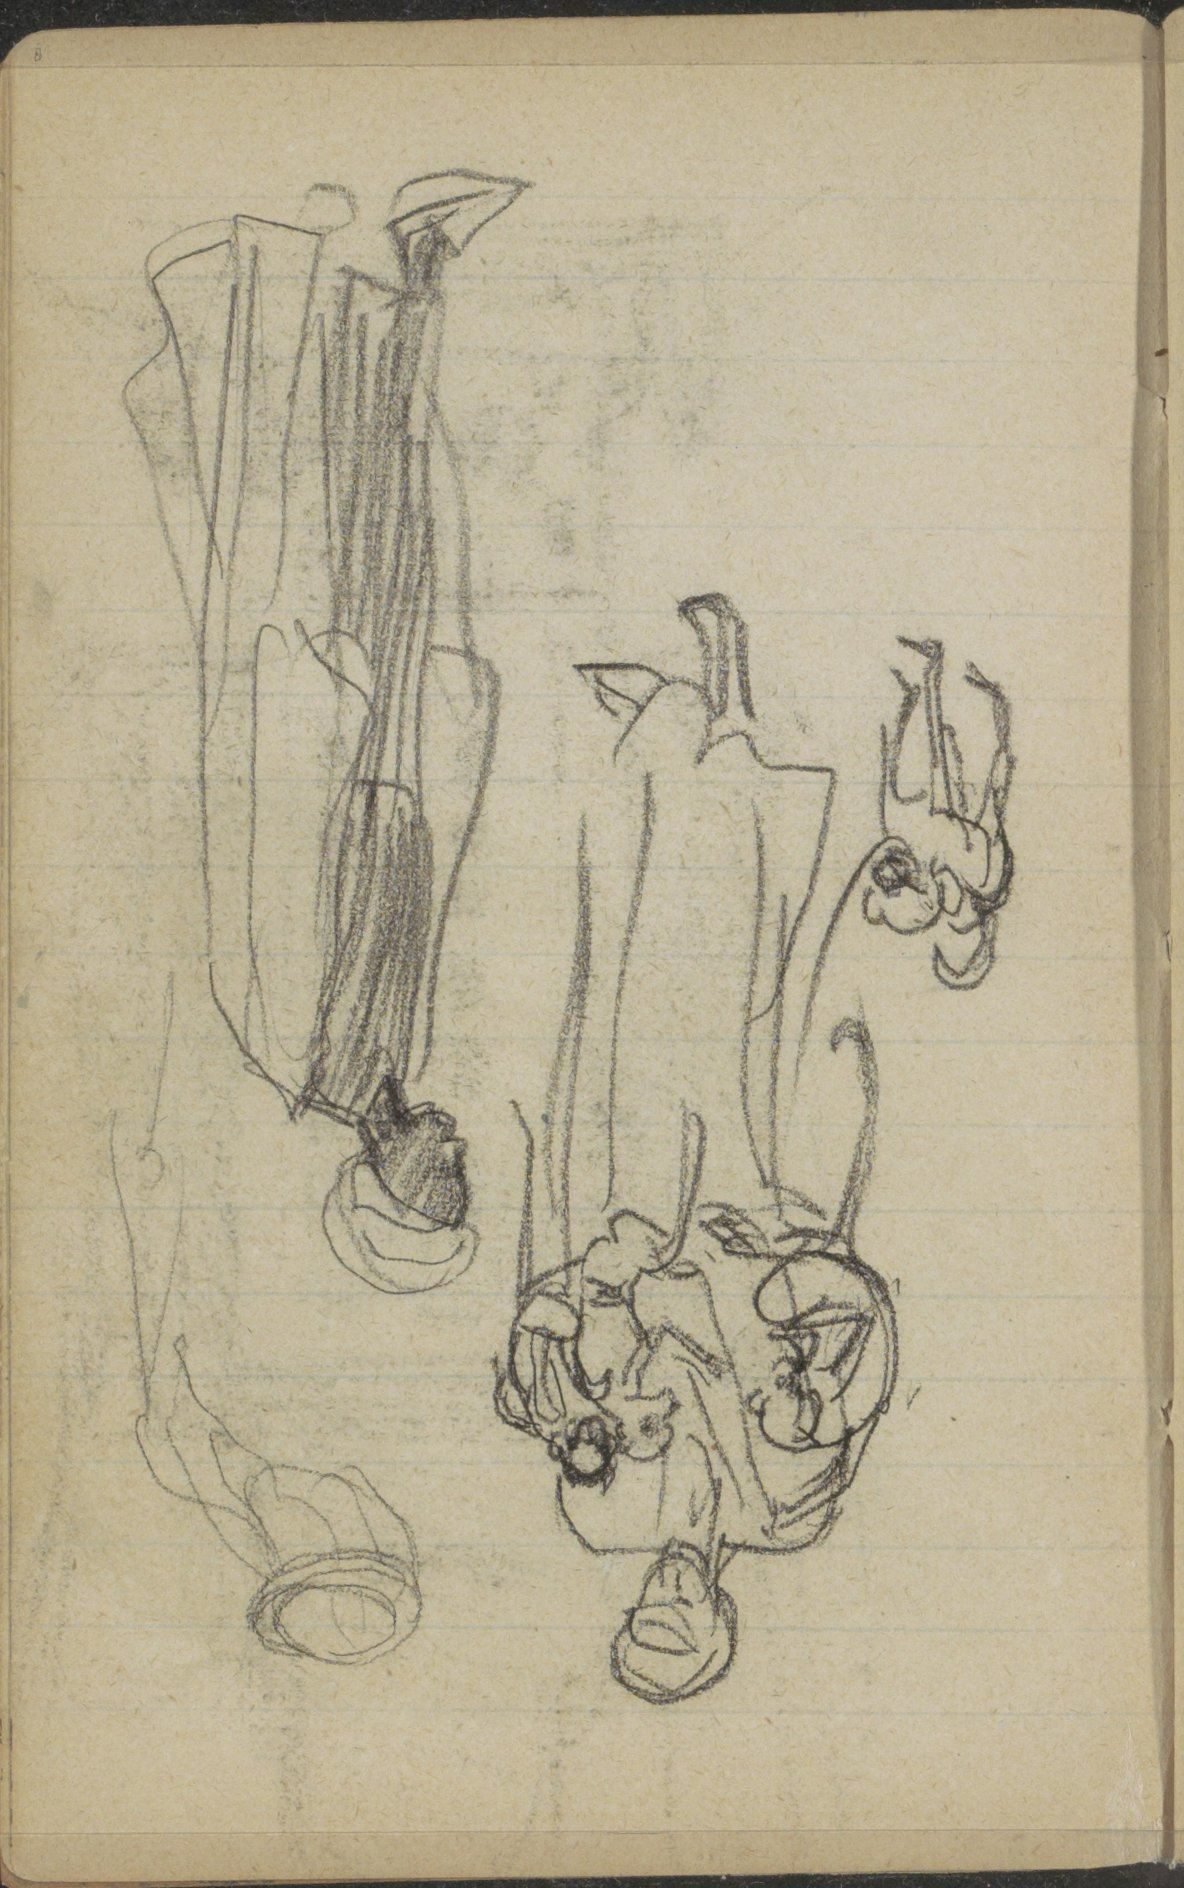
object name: sketchbook leaf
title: Egyptenaar met apen op de arm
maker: marius bauer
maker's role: draughtsman, print maker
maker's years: 1867-1932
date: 1894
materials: chalk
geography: egypt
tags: standing figure, monkeys, apes, africans, walking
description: Tevens een studie van een wandelende Egyptenaar en een hoofddeksel. Pagina 8 uit een schetsboek met 48 bladen.